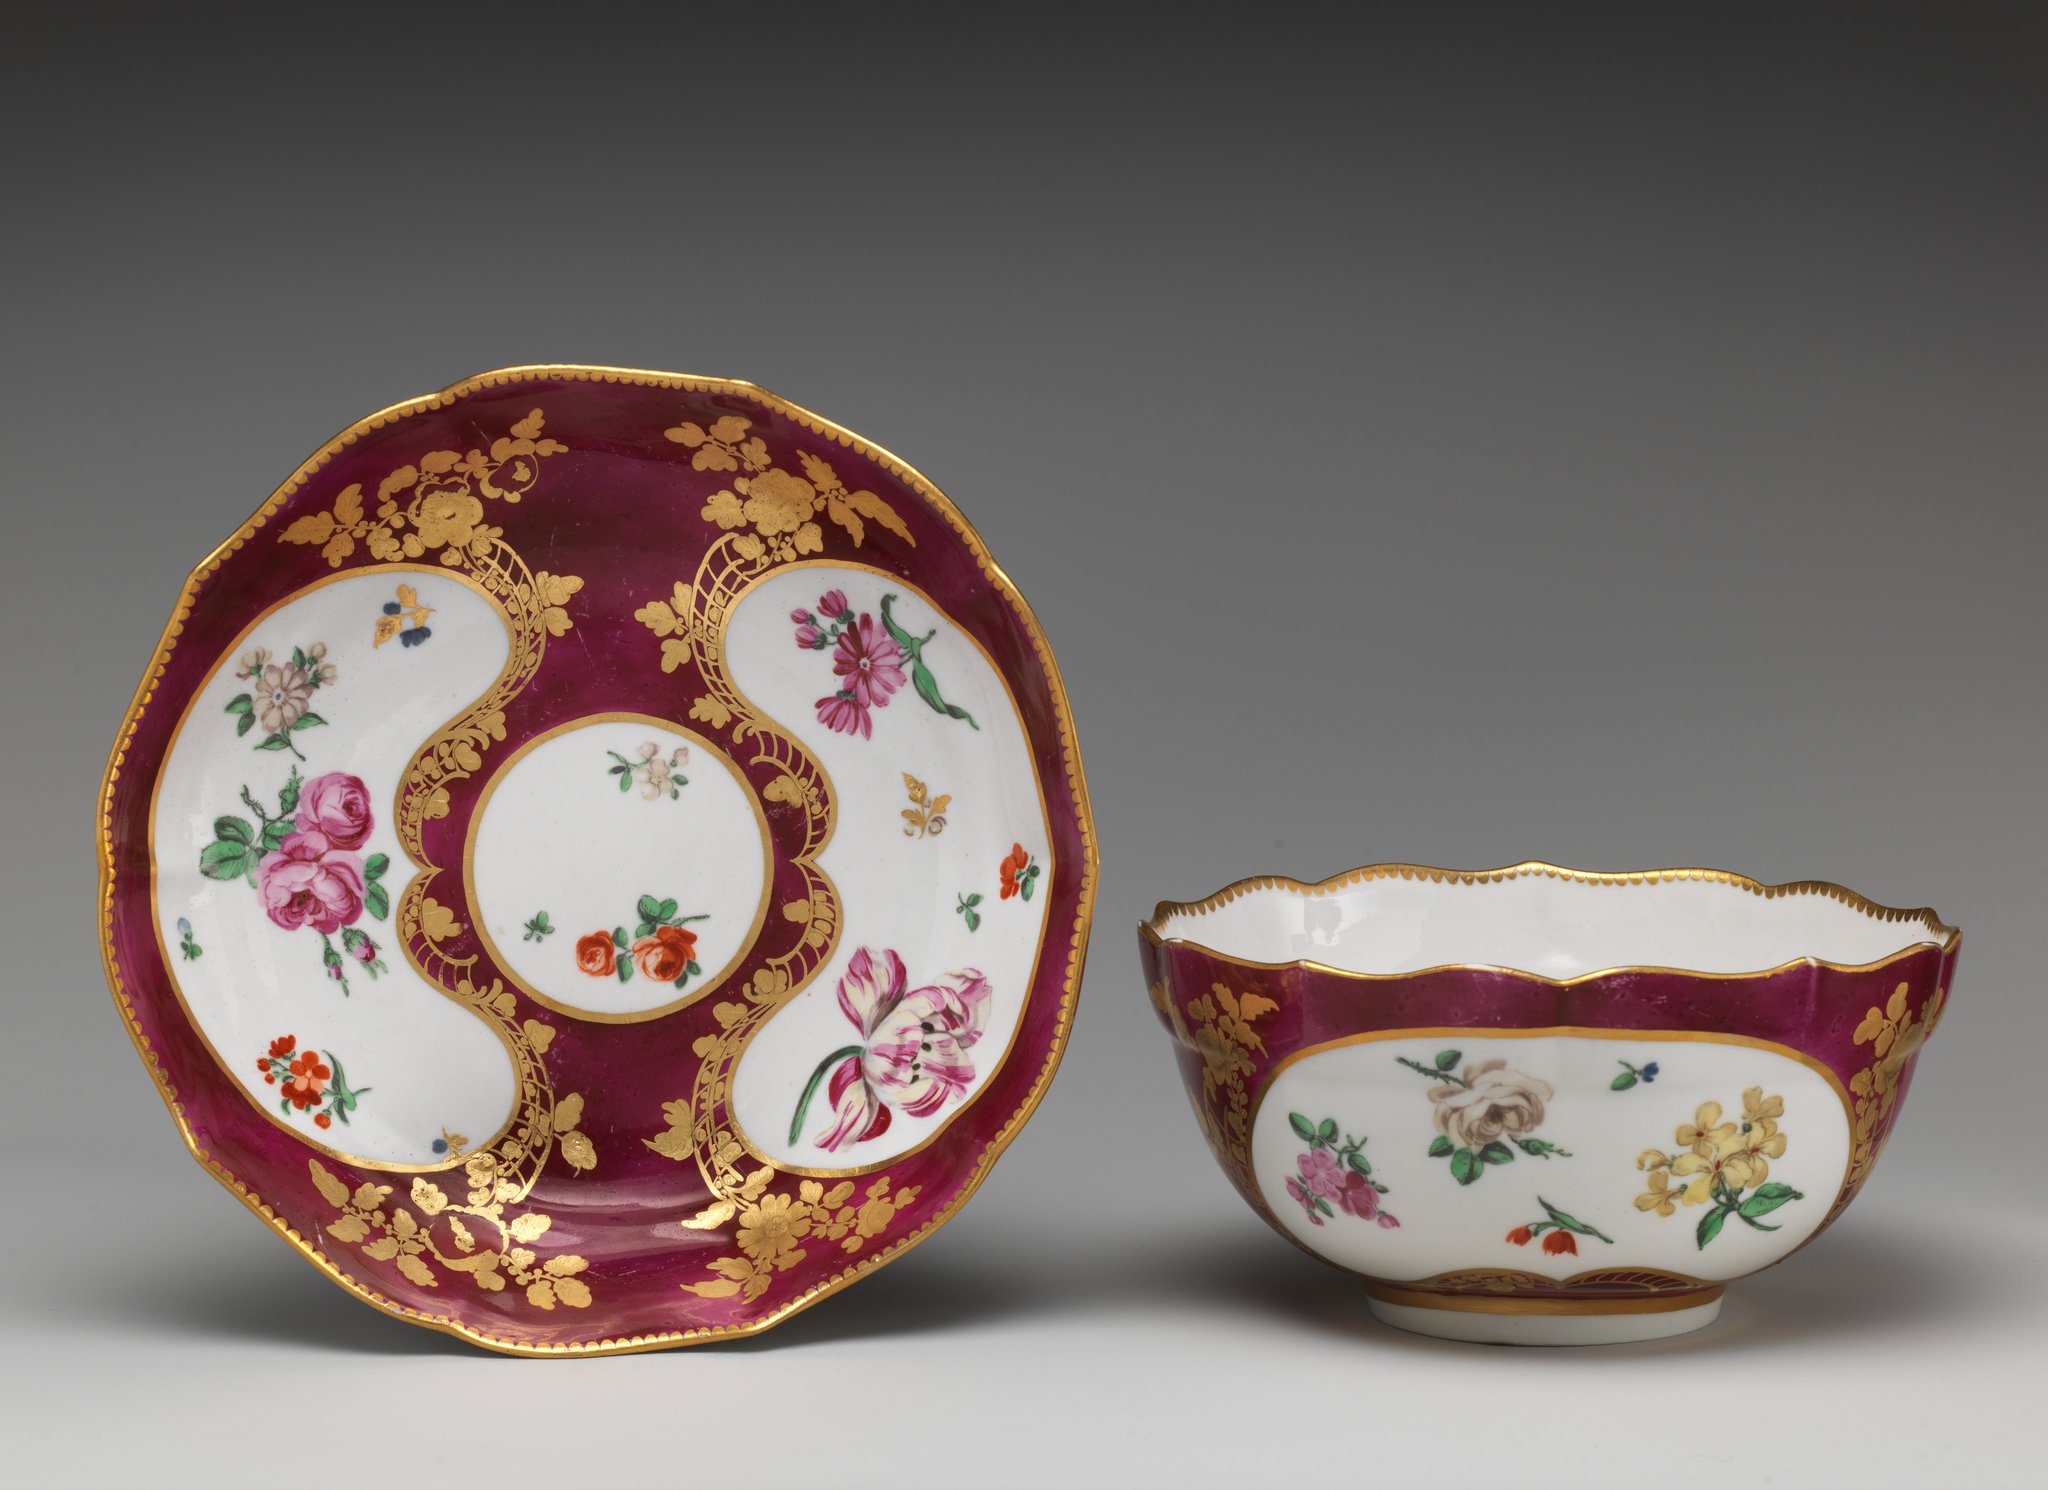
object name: bowl and tray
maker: chelsea porcelain manufactory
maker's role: factory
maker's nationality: british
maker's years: 1744-1784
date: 1765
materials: soft paste porcelain